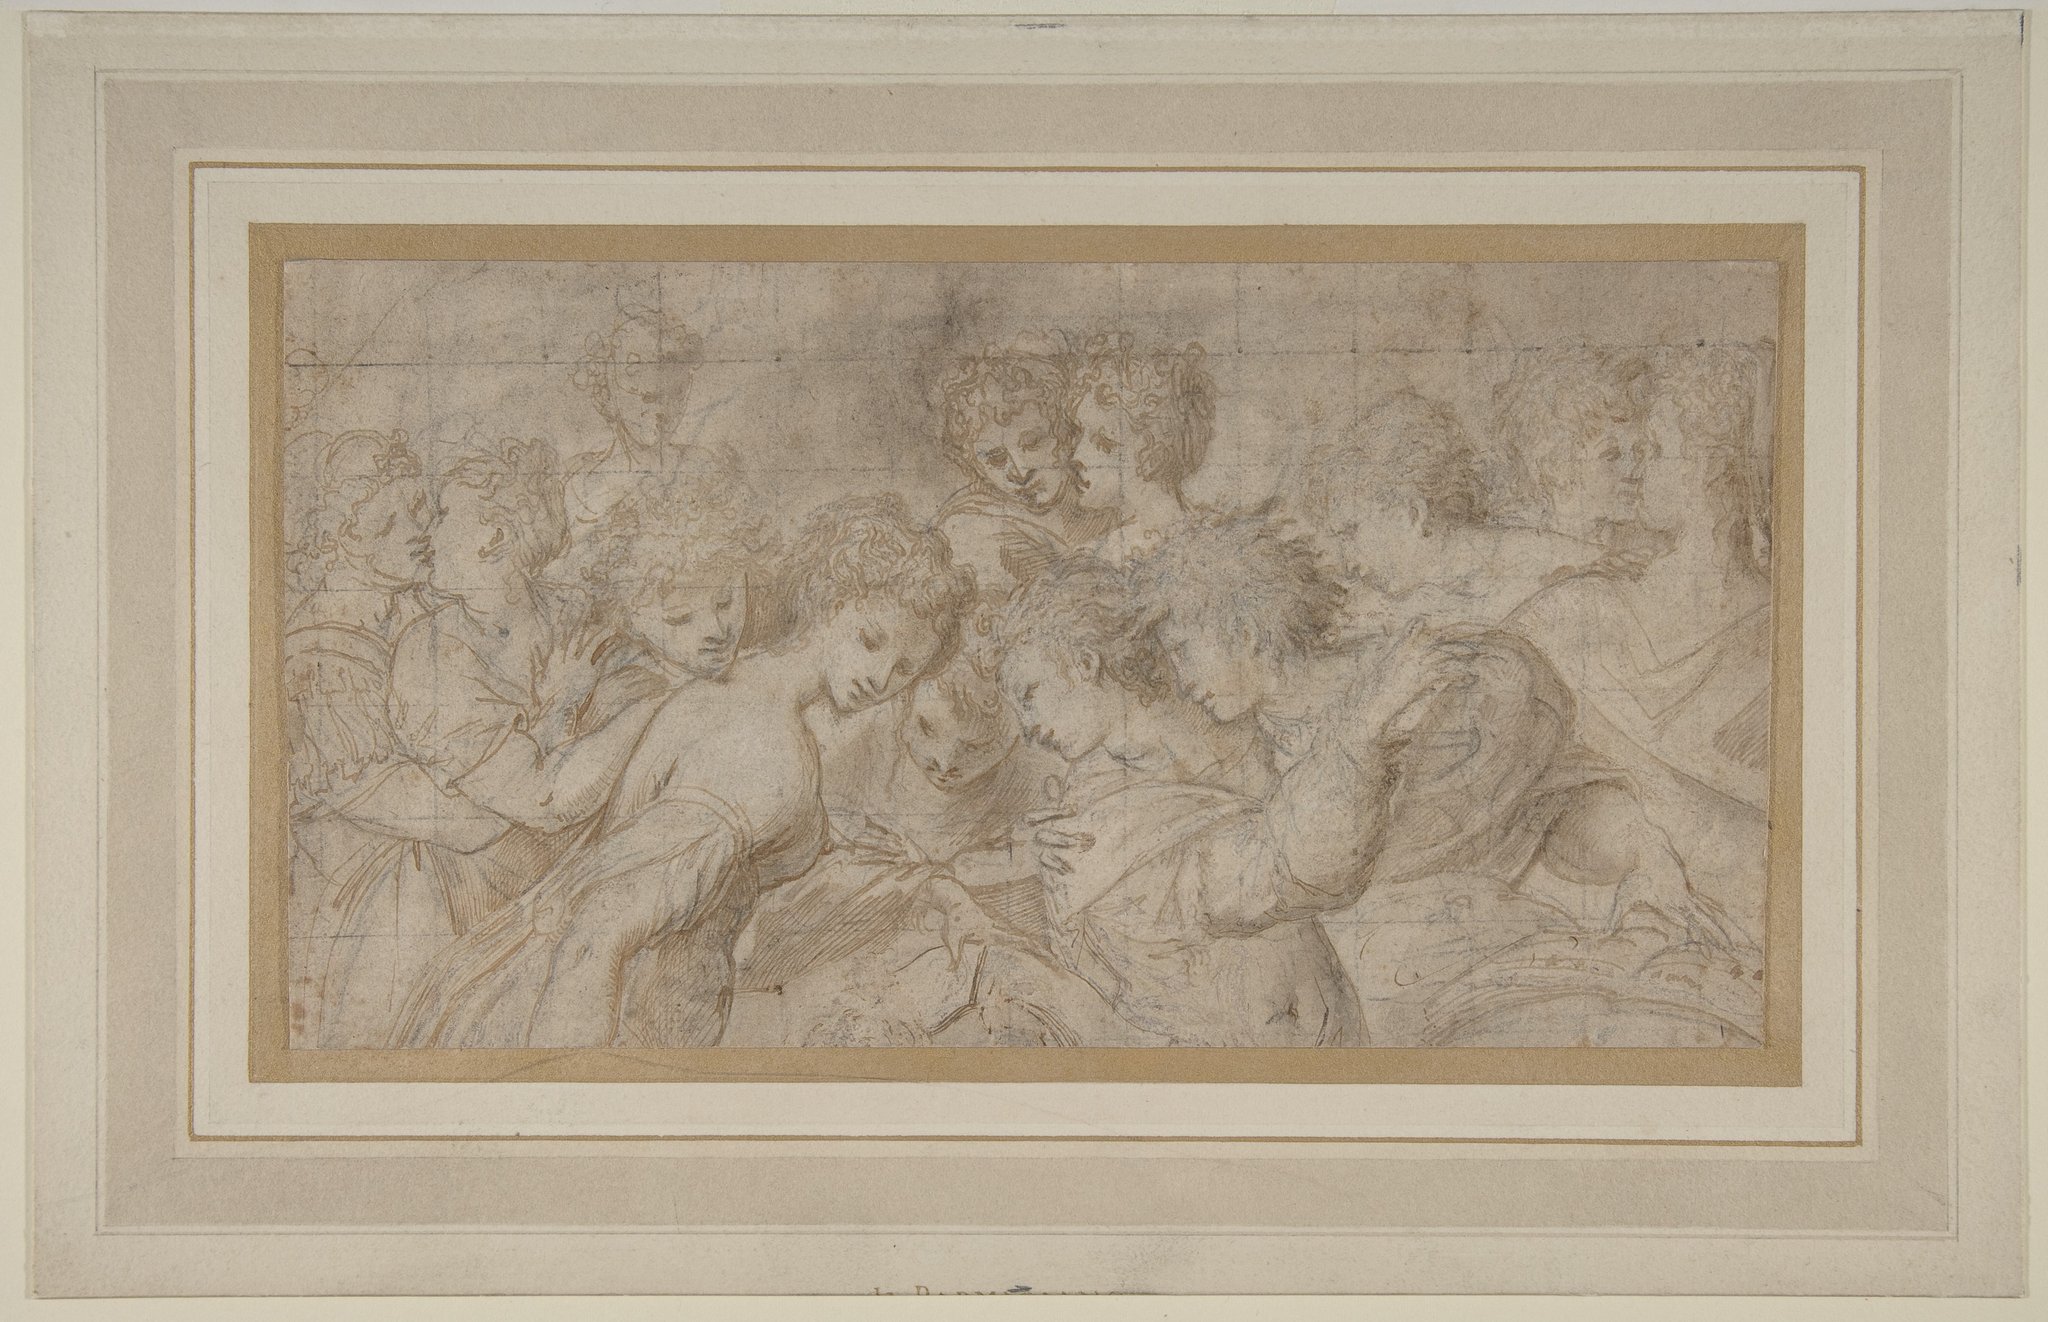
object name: drawing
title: Embracing Female Figures, Some Holding Musical Scores.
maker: girolamo mirola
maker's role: artist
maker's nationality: italian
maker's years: 1562-1570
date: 1570-1573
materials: chalk, gouache, ink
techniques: brush, highlighting, pen, drawing, wash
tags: women